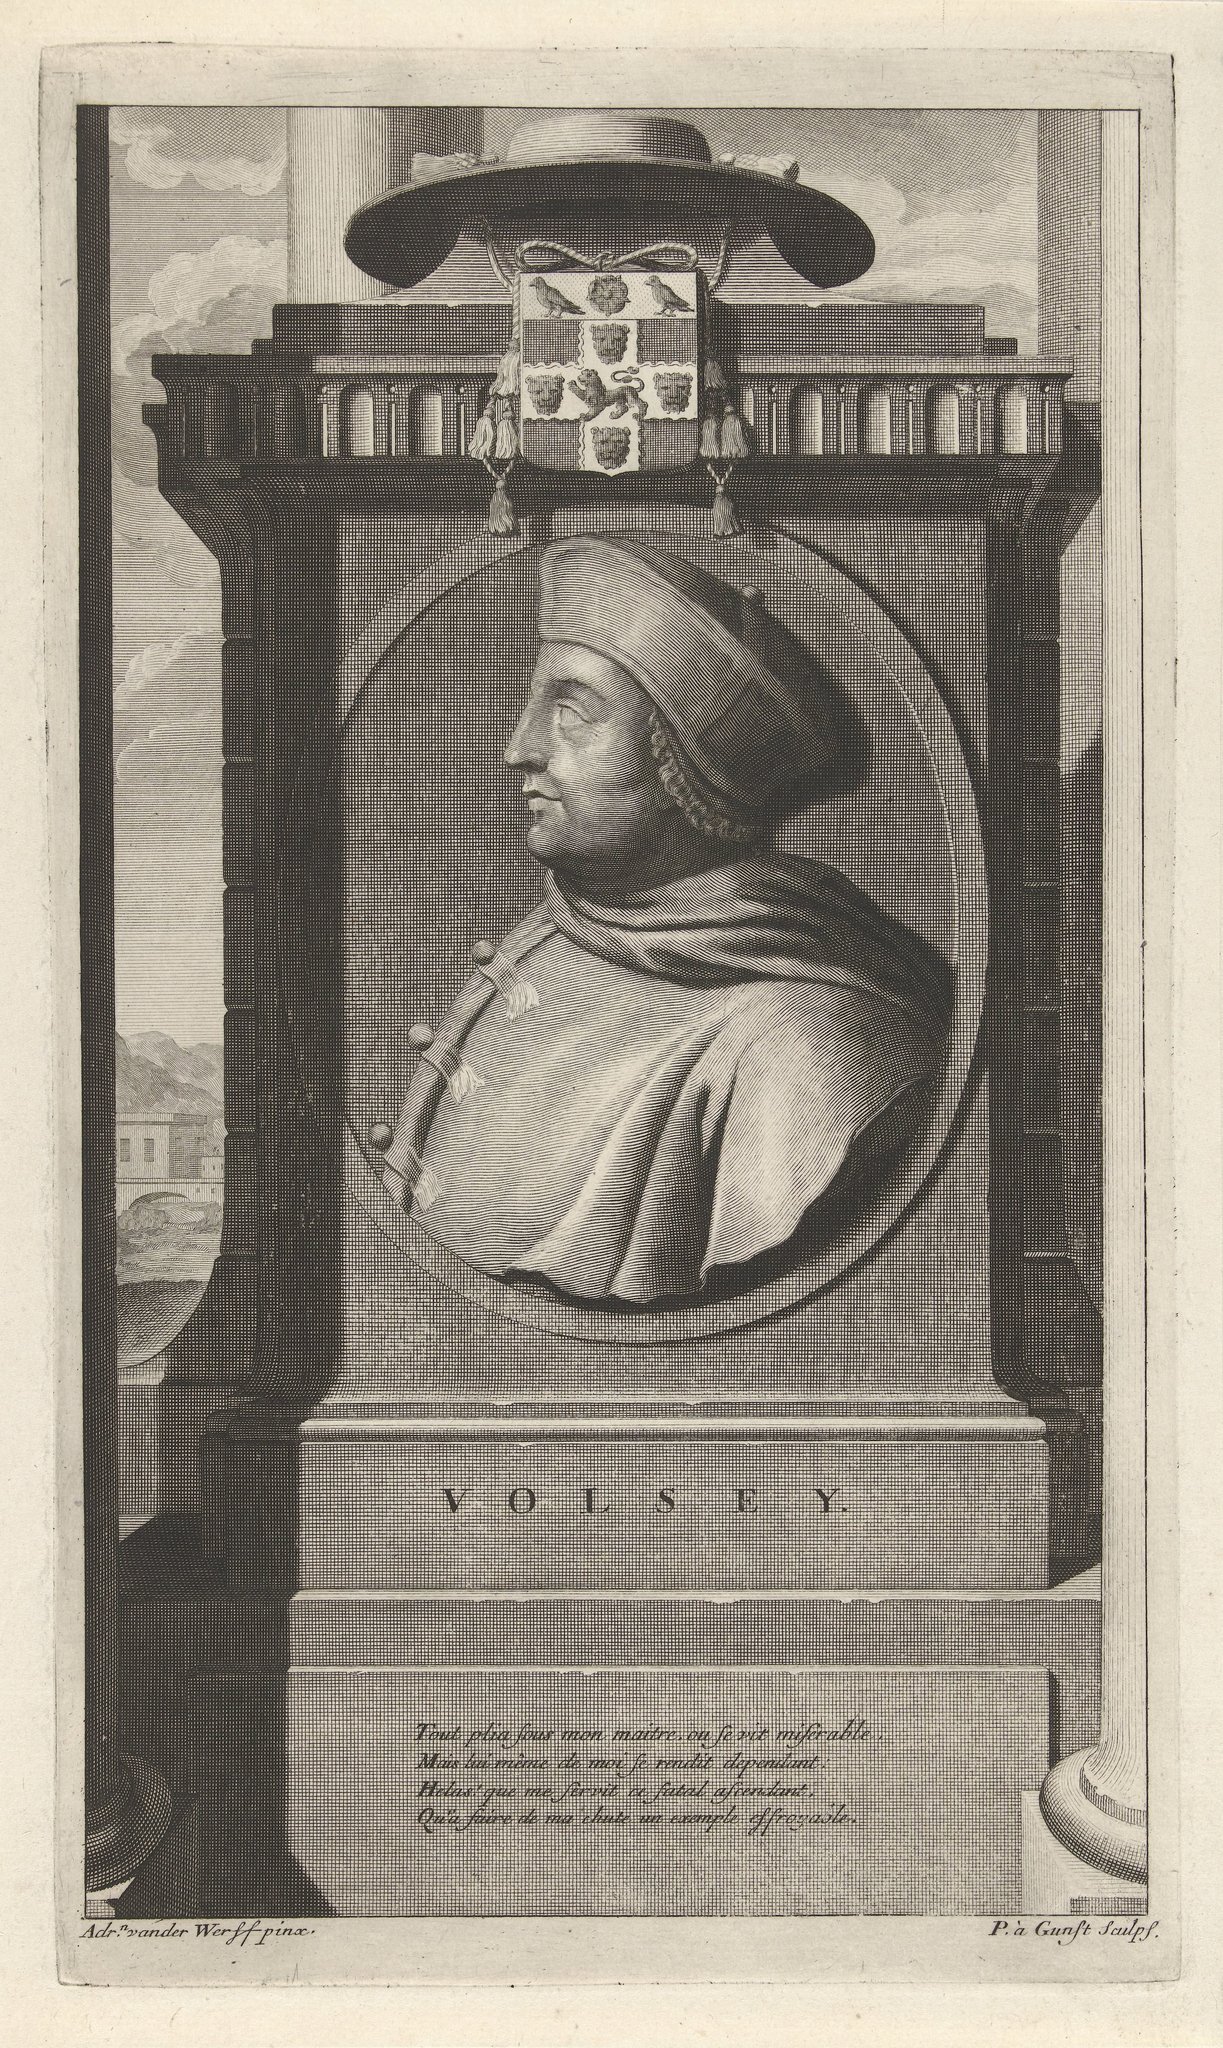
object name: print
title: Portret van kardinaal Wolsey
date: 1669-1731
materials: paper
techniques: engraving, etching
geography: amsterdam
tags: kardinaal, thomas wolsey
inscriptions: collector's mark: Lugt 2228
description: Kardinaal Wolsey, Lord Chancellor van Engeland in de vroege regeringsperiode van Hendrik VIII. Boven het portret zijn wapenschild. De prent heeft als onderschrift een Frans gedicht over zijn politieke ondergang.